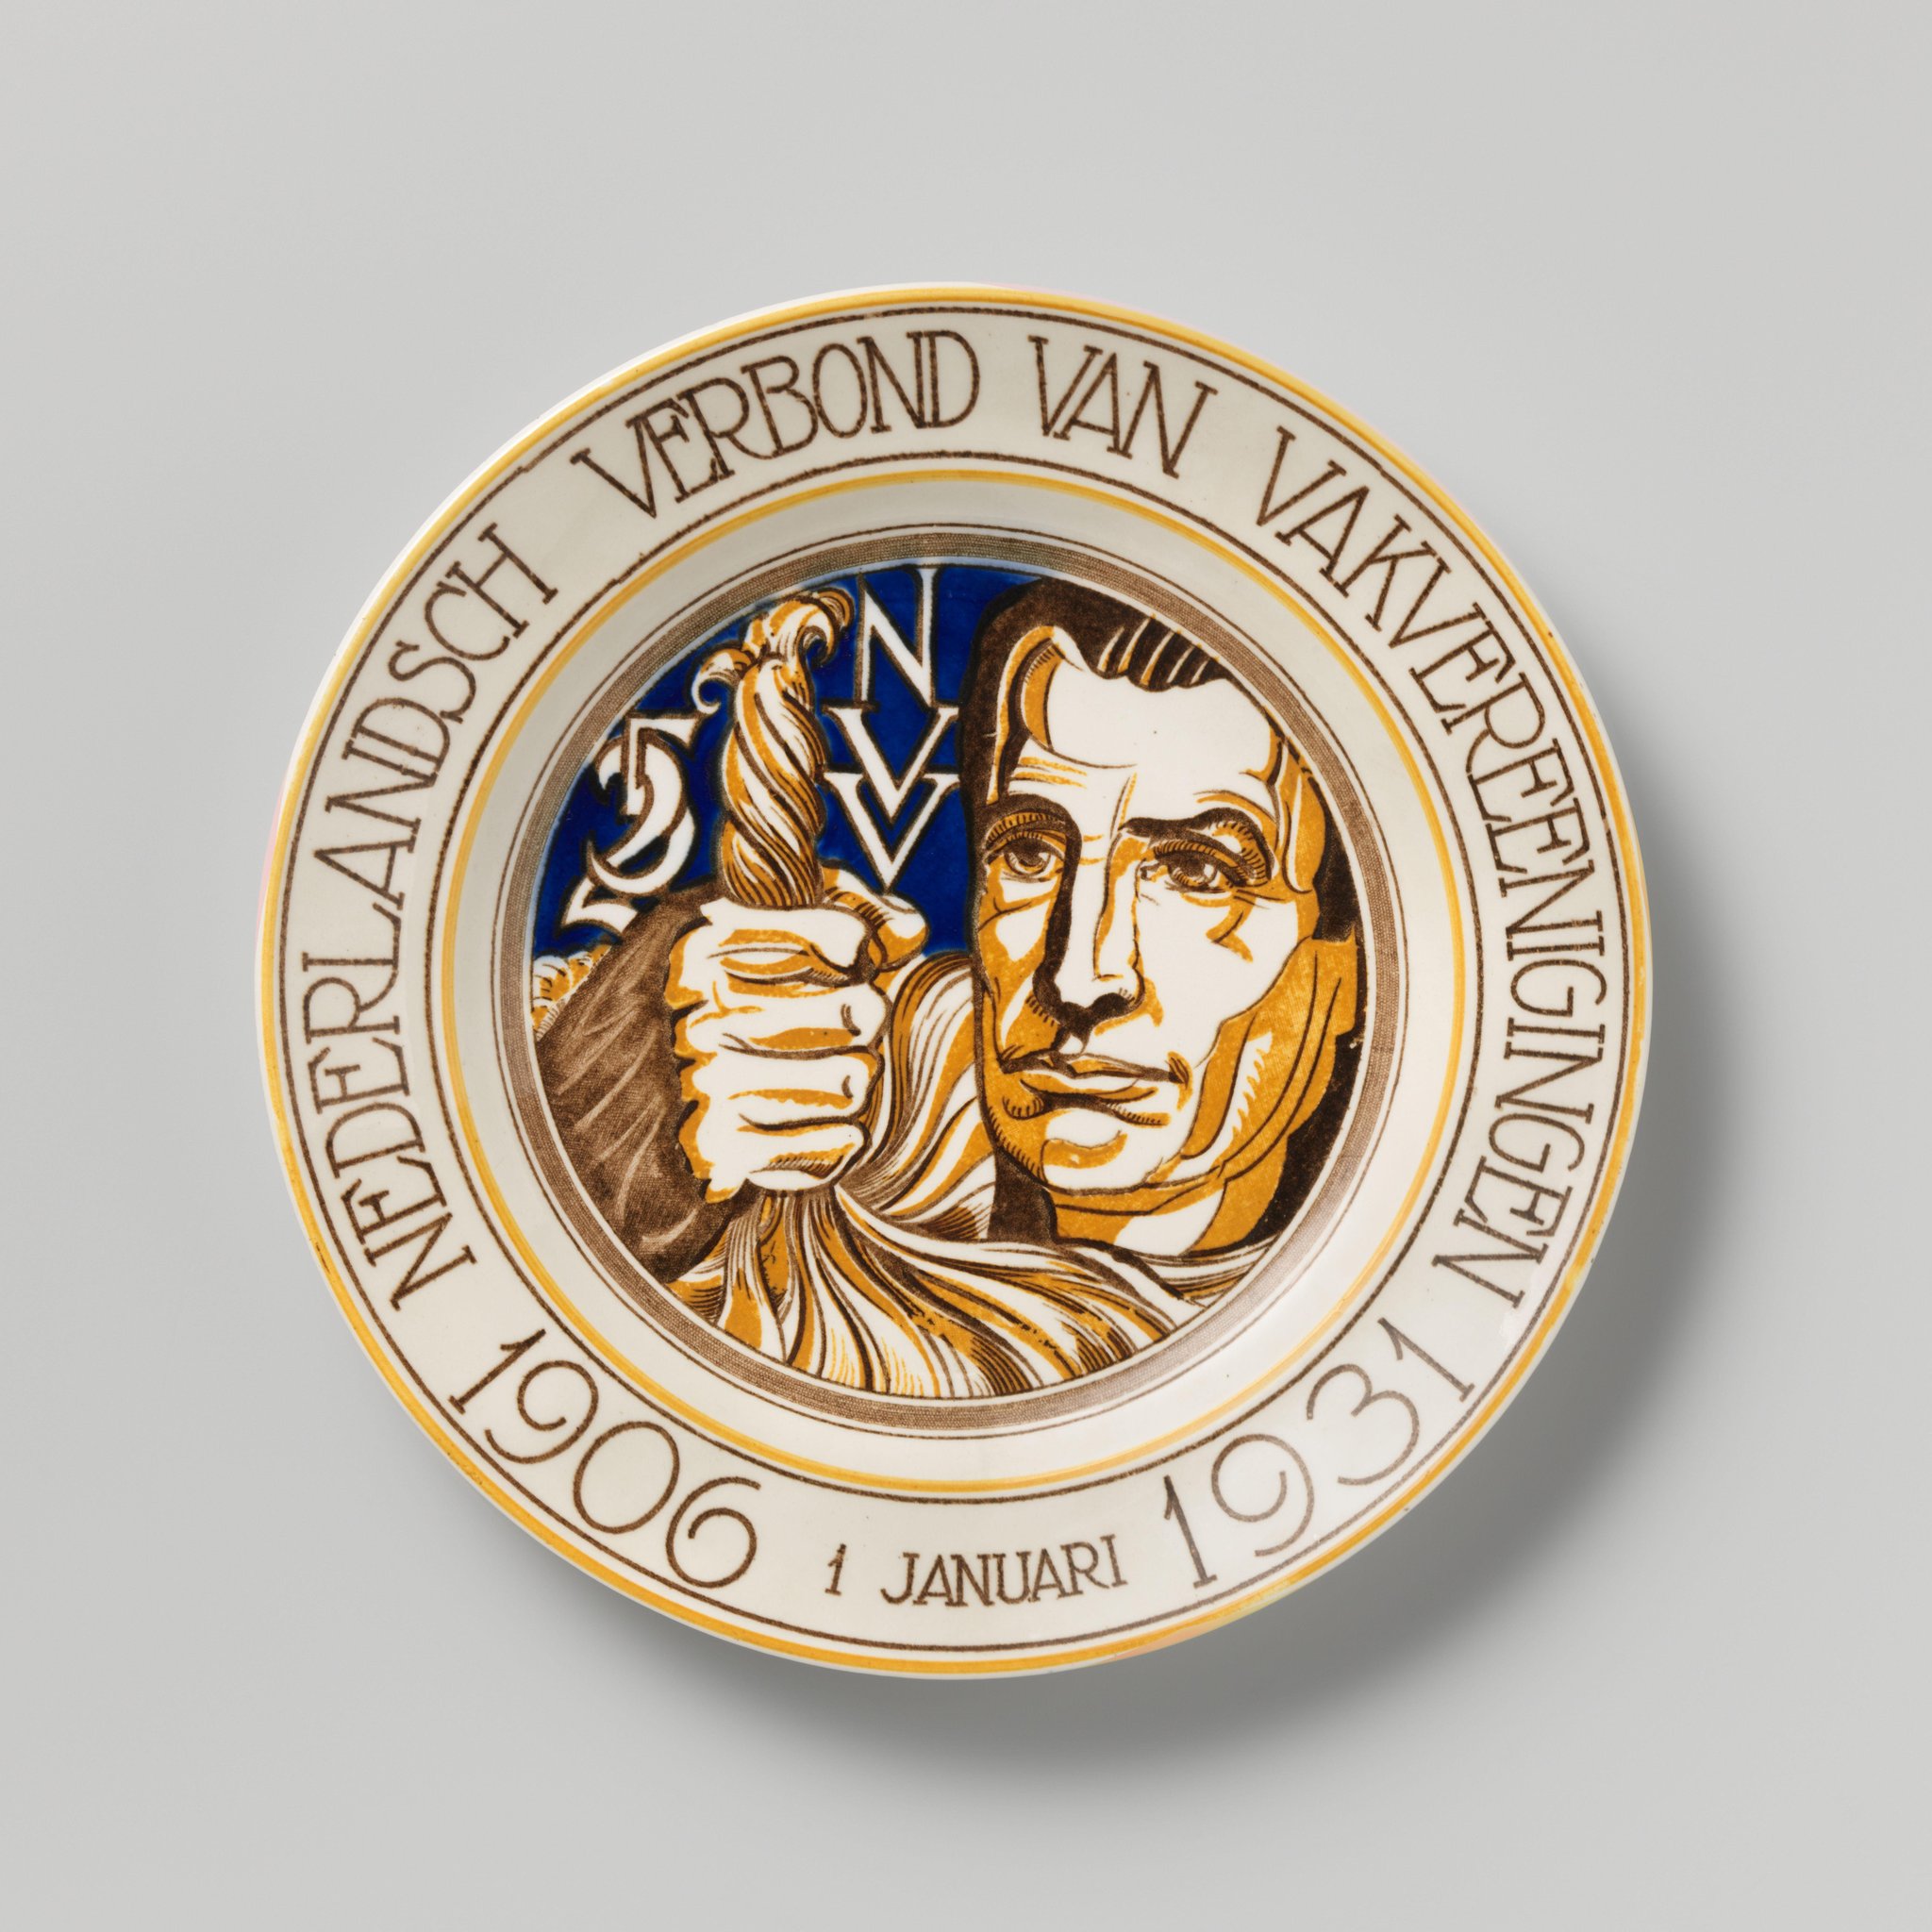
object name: commemorative plate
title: 25 Jaar Nederlandsch Verbond van Vakverenigingen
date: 1931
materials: earthenware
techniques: firing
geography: maastricht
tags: netherlands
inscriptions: inscription: ‘25 NVV’, mark: ‘7 3/4 8’, inscription: ‘NEDERLANDSCH VERBOND VAN VAKVERENIGINGEN 1906 1 JANUARI 1931’, mark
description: Commemorative plate for the 25th anniversary (1906-1931) of the Dutch trade union association, the Nederlandsch Verbond van Vakvereenigingen (NVV). The NVV were social democrats.